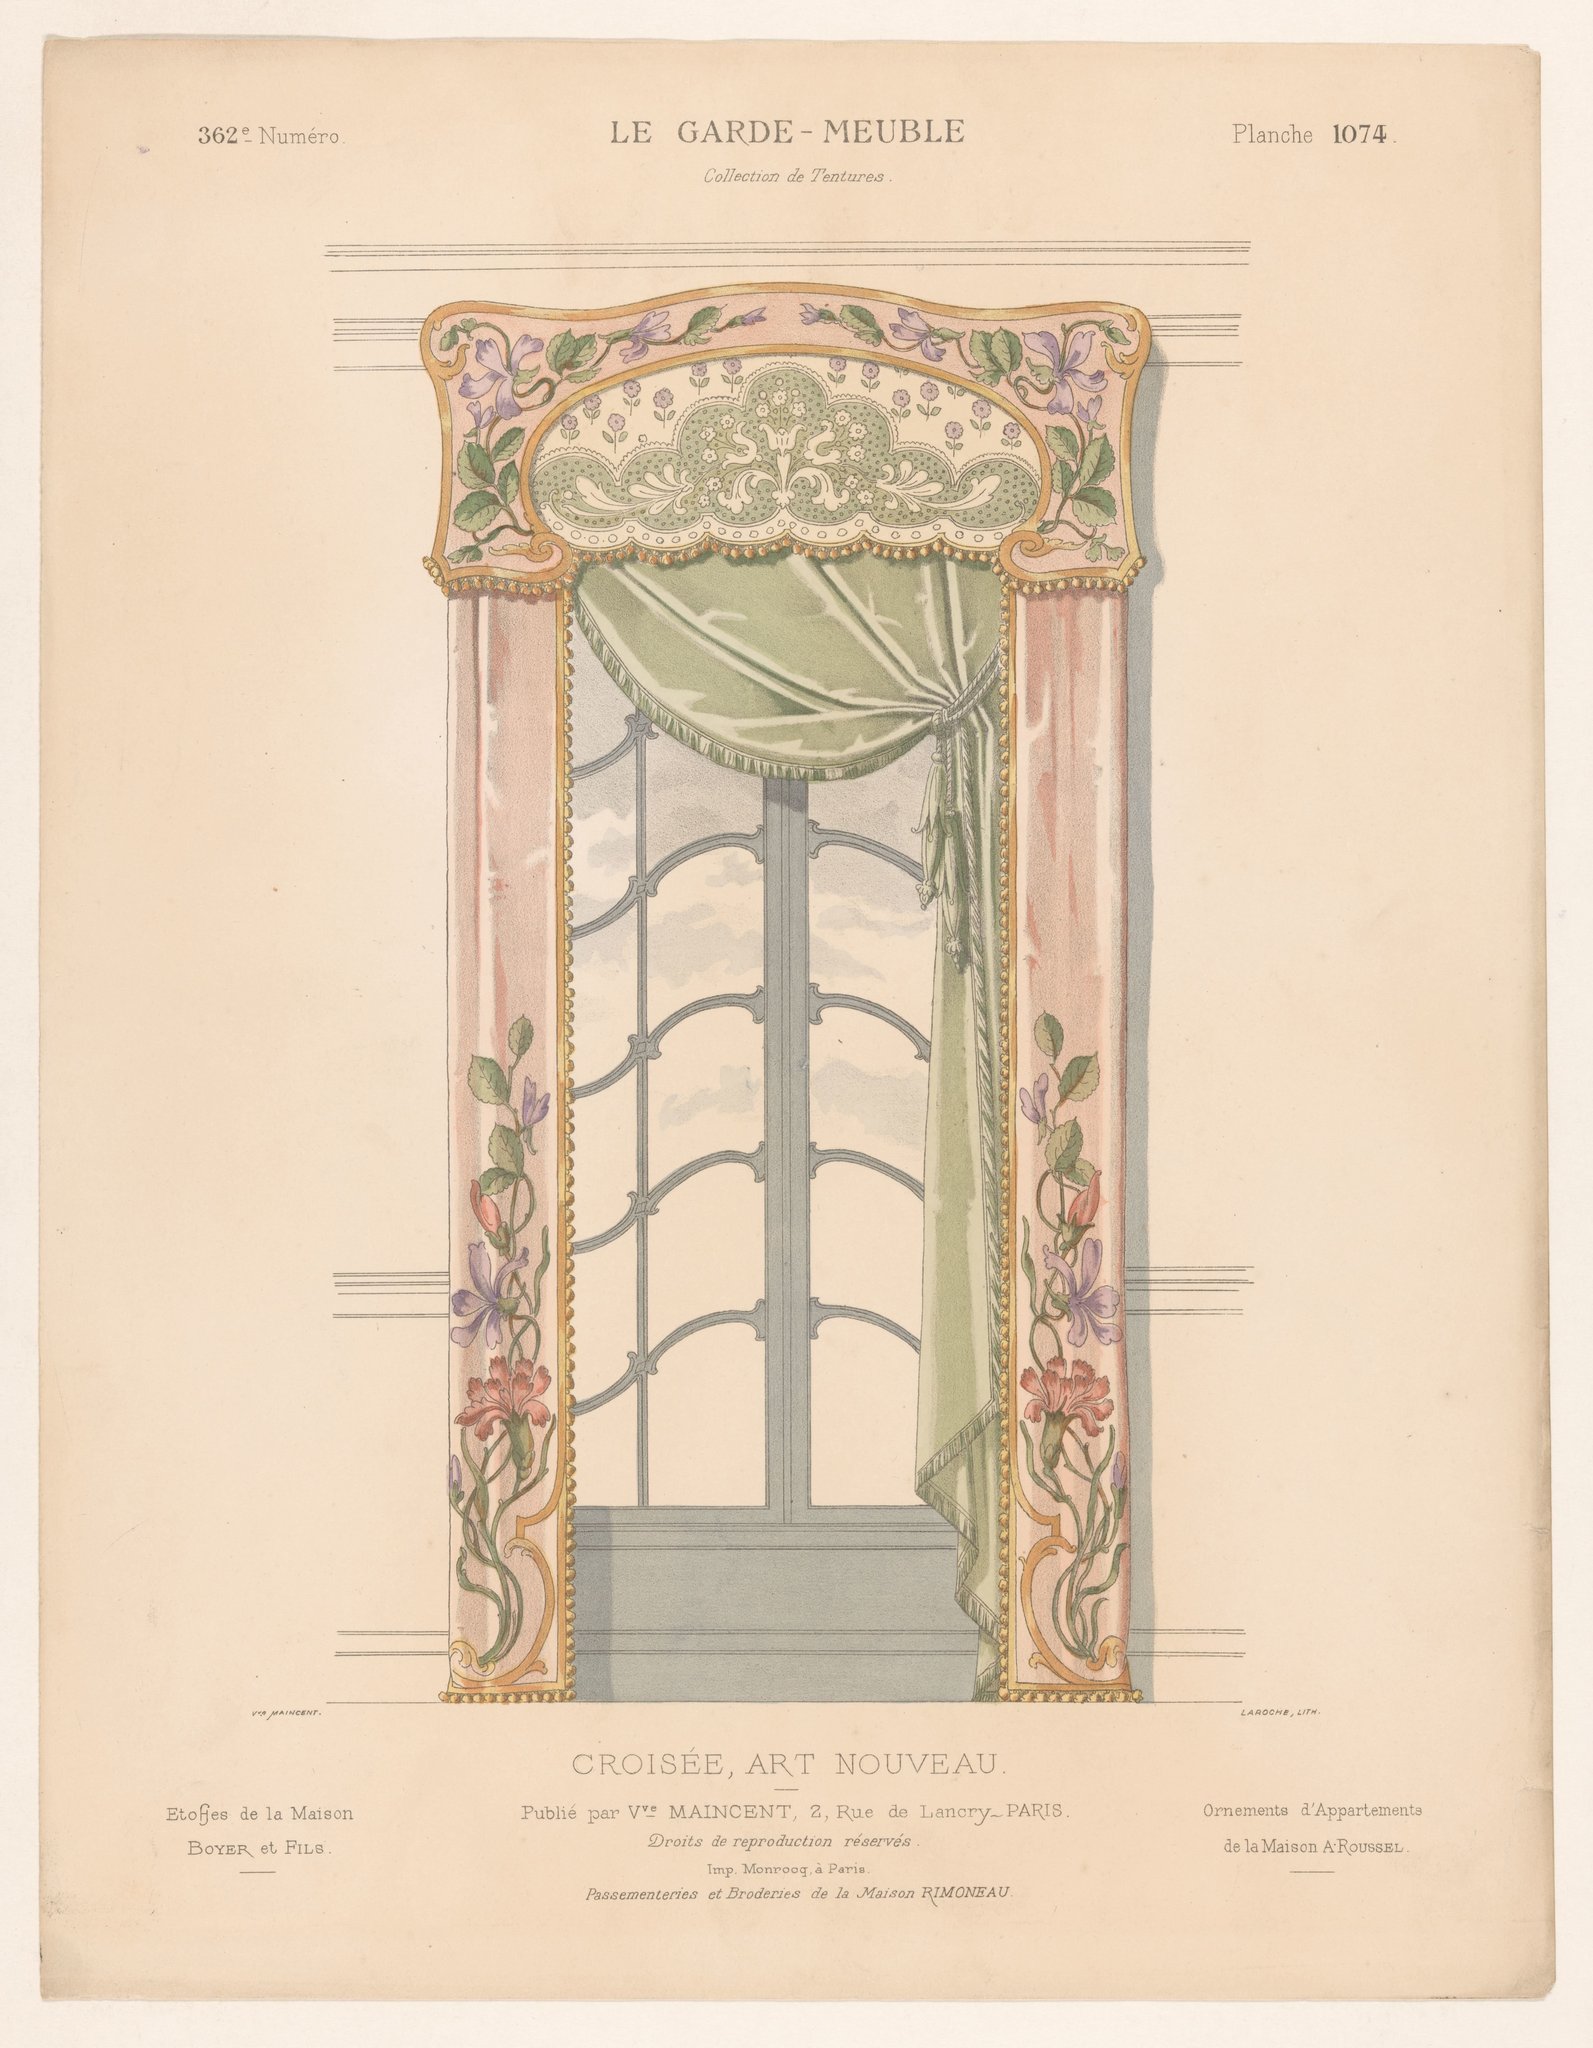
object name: print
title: Venster met gordijnen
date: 1895-1910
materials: paper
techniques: hand coloring, lithograph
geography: paris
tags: window, hangings and drapery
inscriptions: : ‘Droits de reproduction réservés.’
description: Kruisvenster met gedrapeerde gordijnen in art-nouveaustijl. Prent uit 362e Livraison.